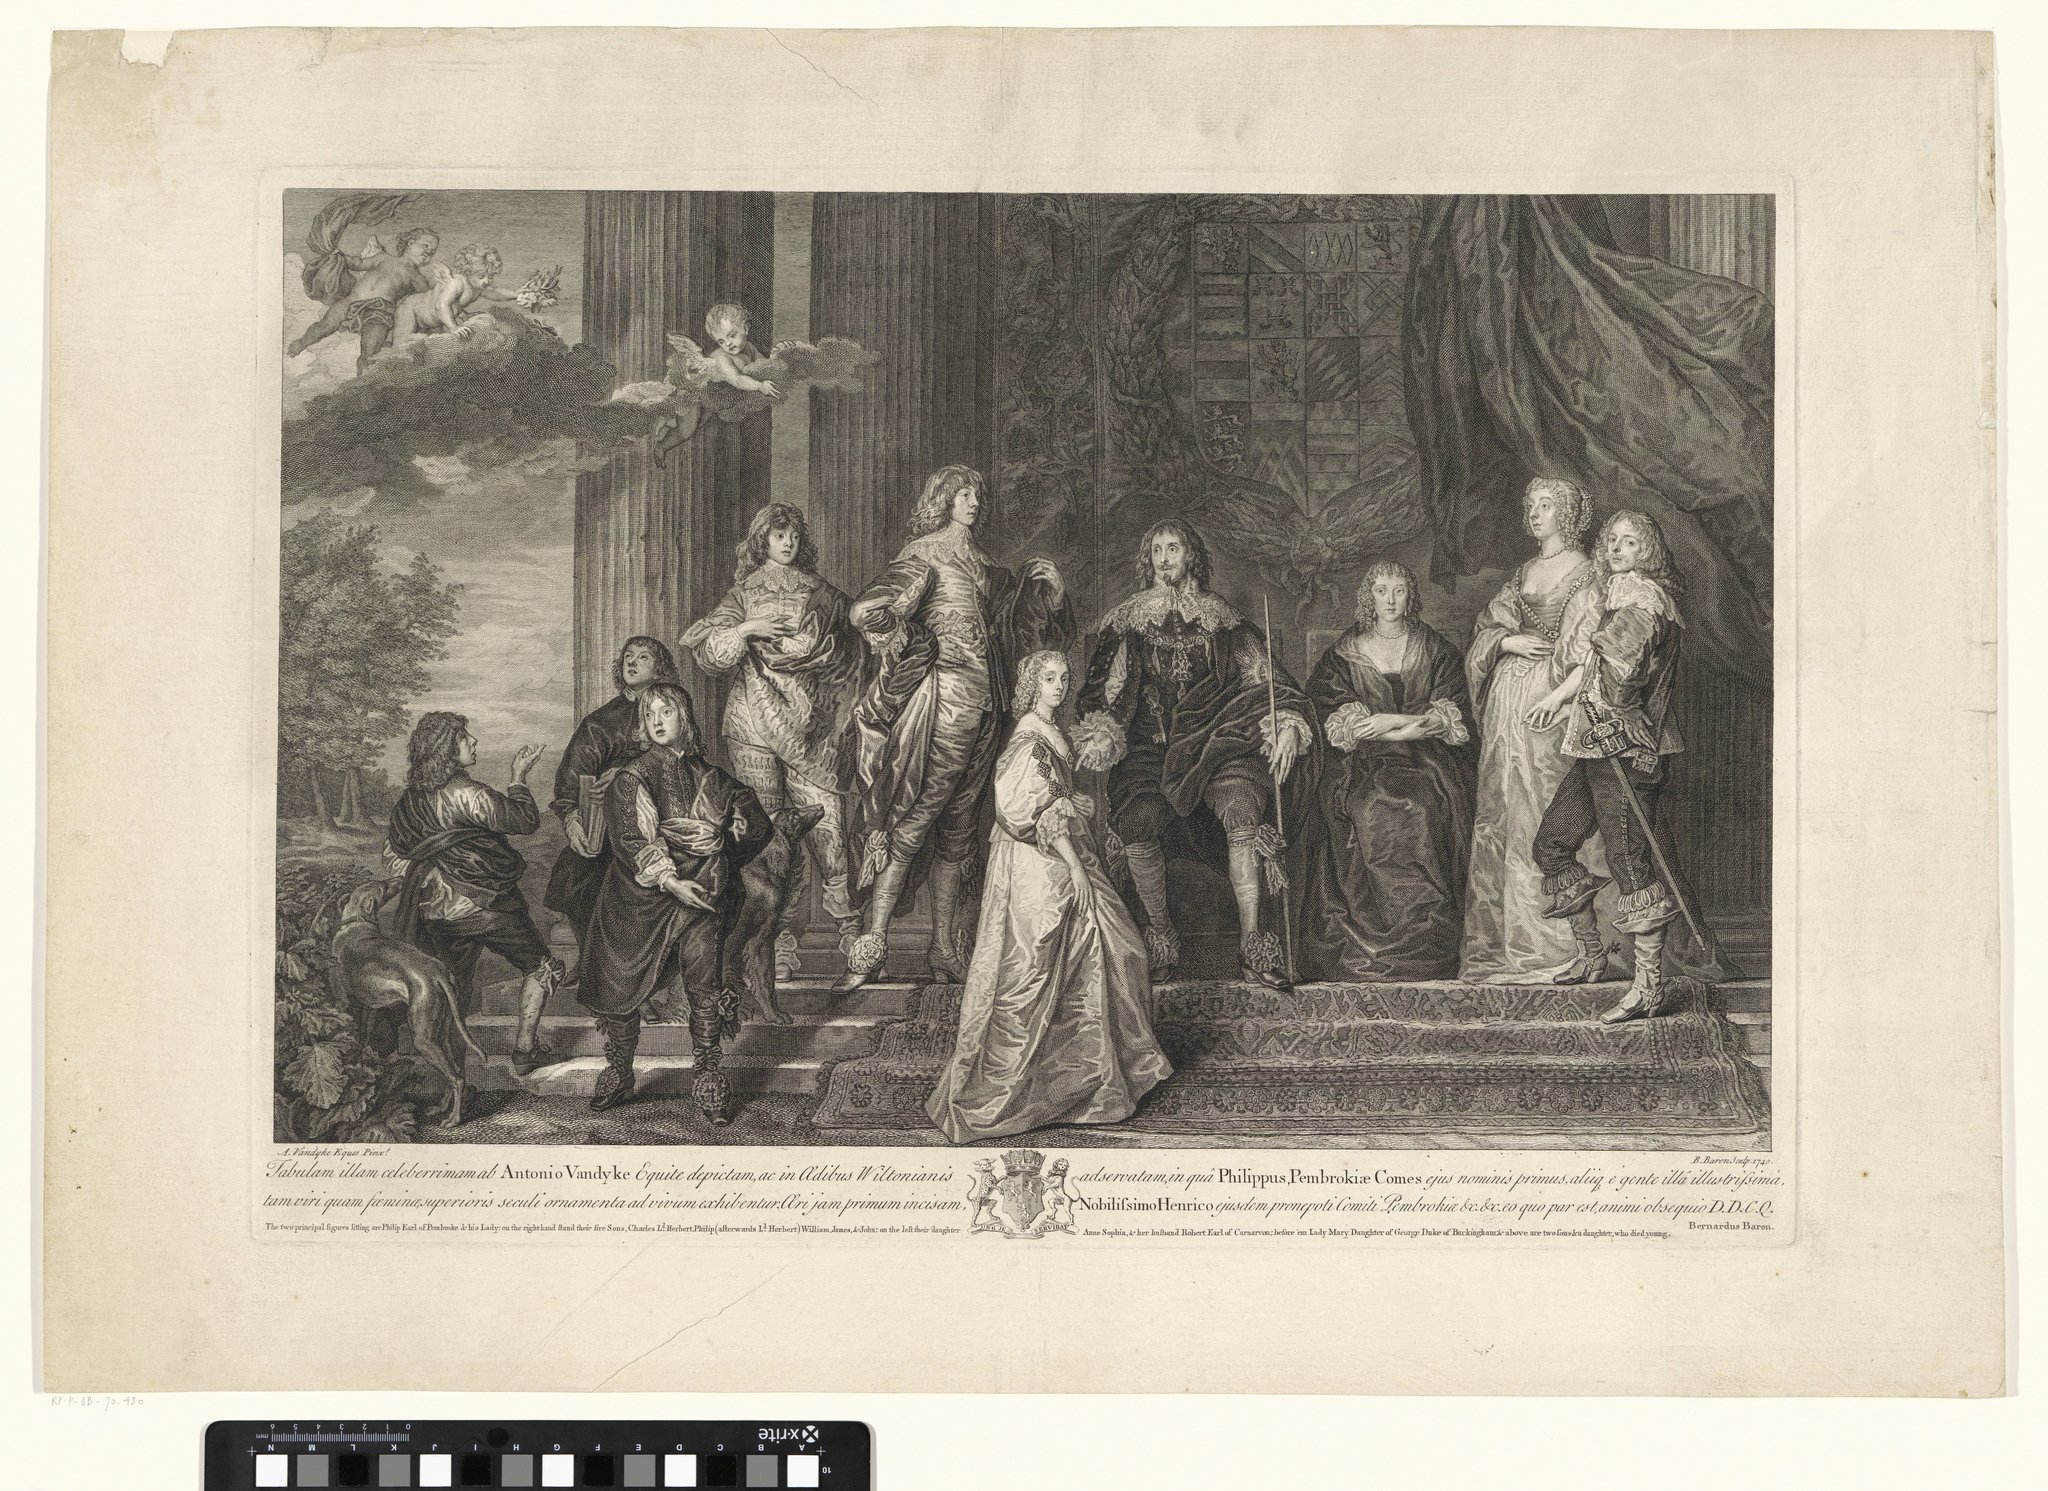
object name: print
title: Portret van Philip Herbert, graaf van Pembroke, met zijn familie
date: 1740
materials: paper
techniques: engraving, etching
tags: historical persons - bb - woman, historical persons, family, relationship, descent, armorial bearing, heraldry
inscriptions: collector's mark: Lugt 240